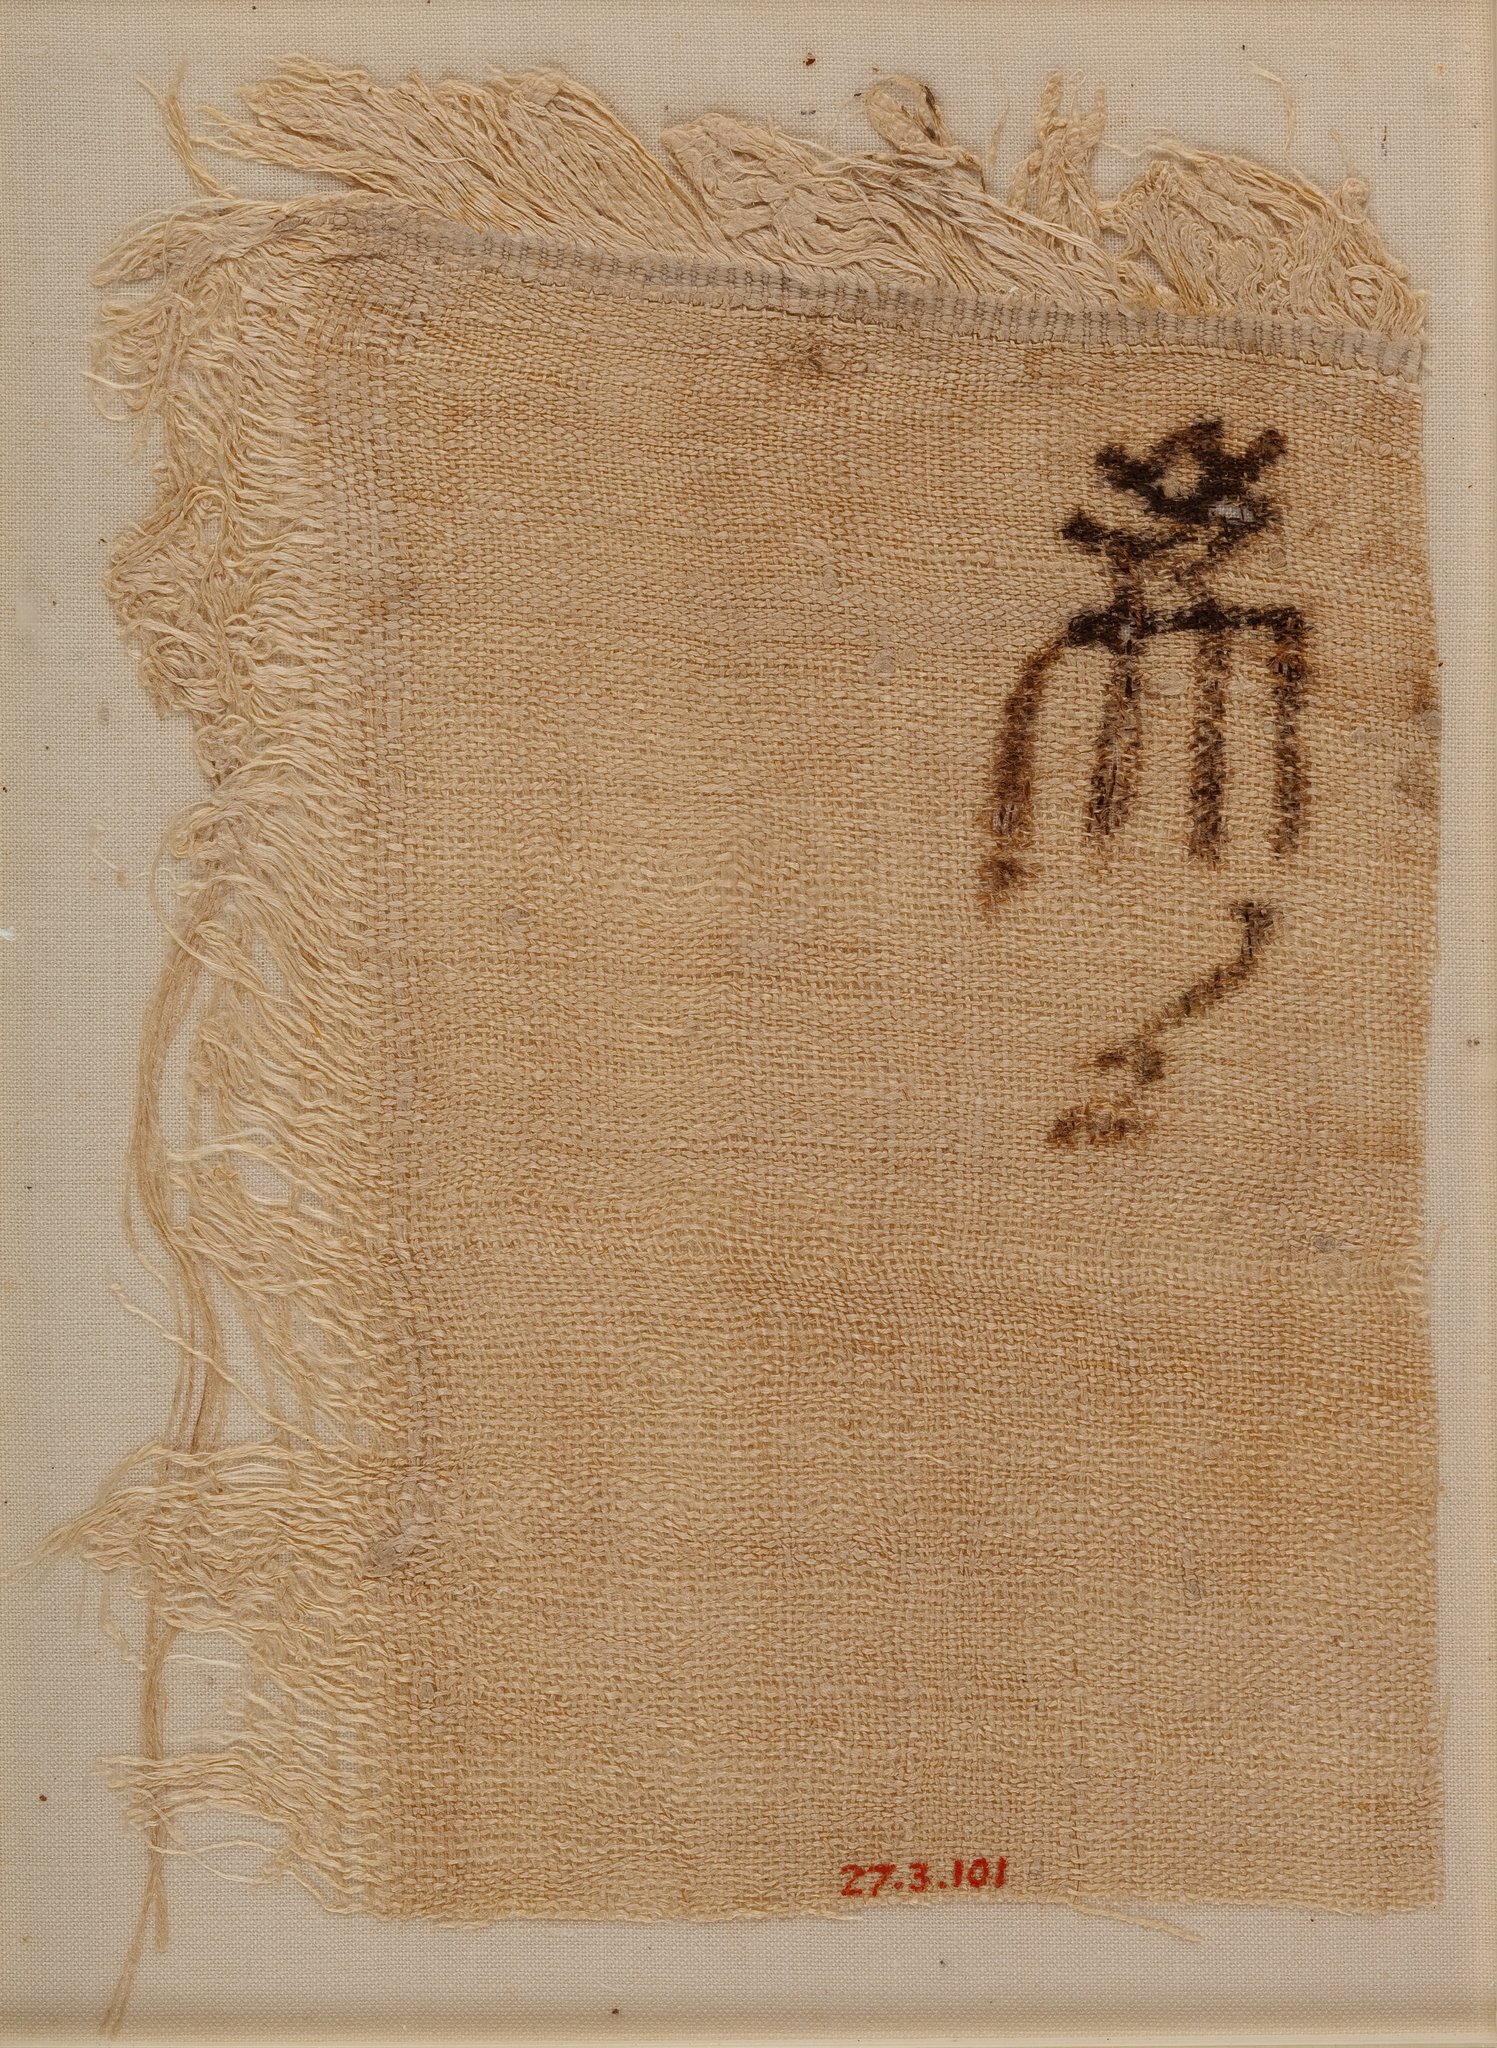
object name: linen mark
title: Linen mark (Type V)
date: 1961-1917 BCE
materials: linen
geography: egypt